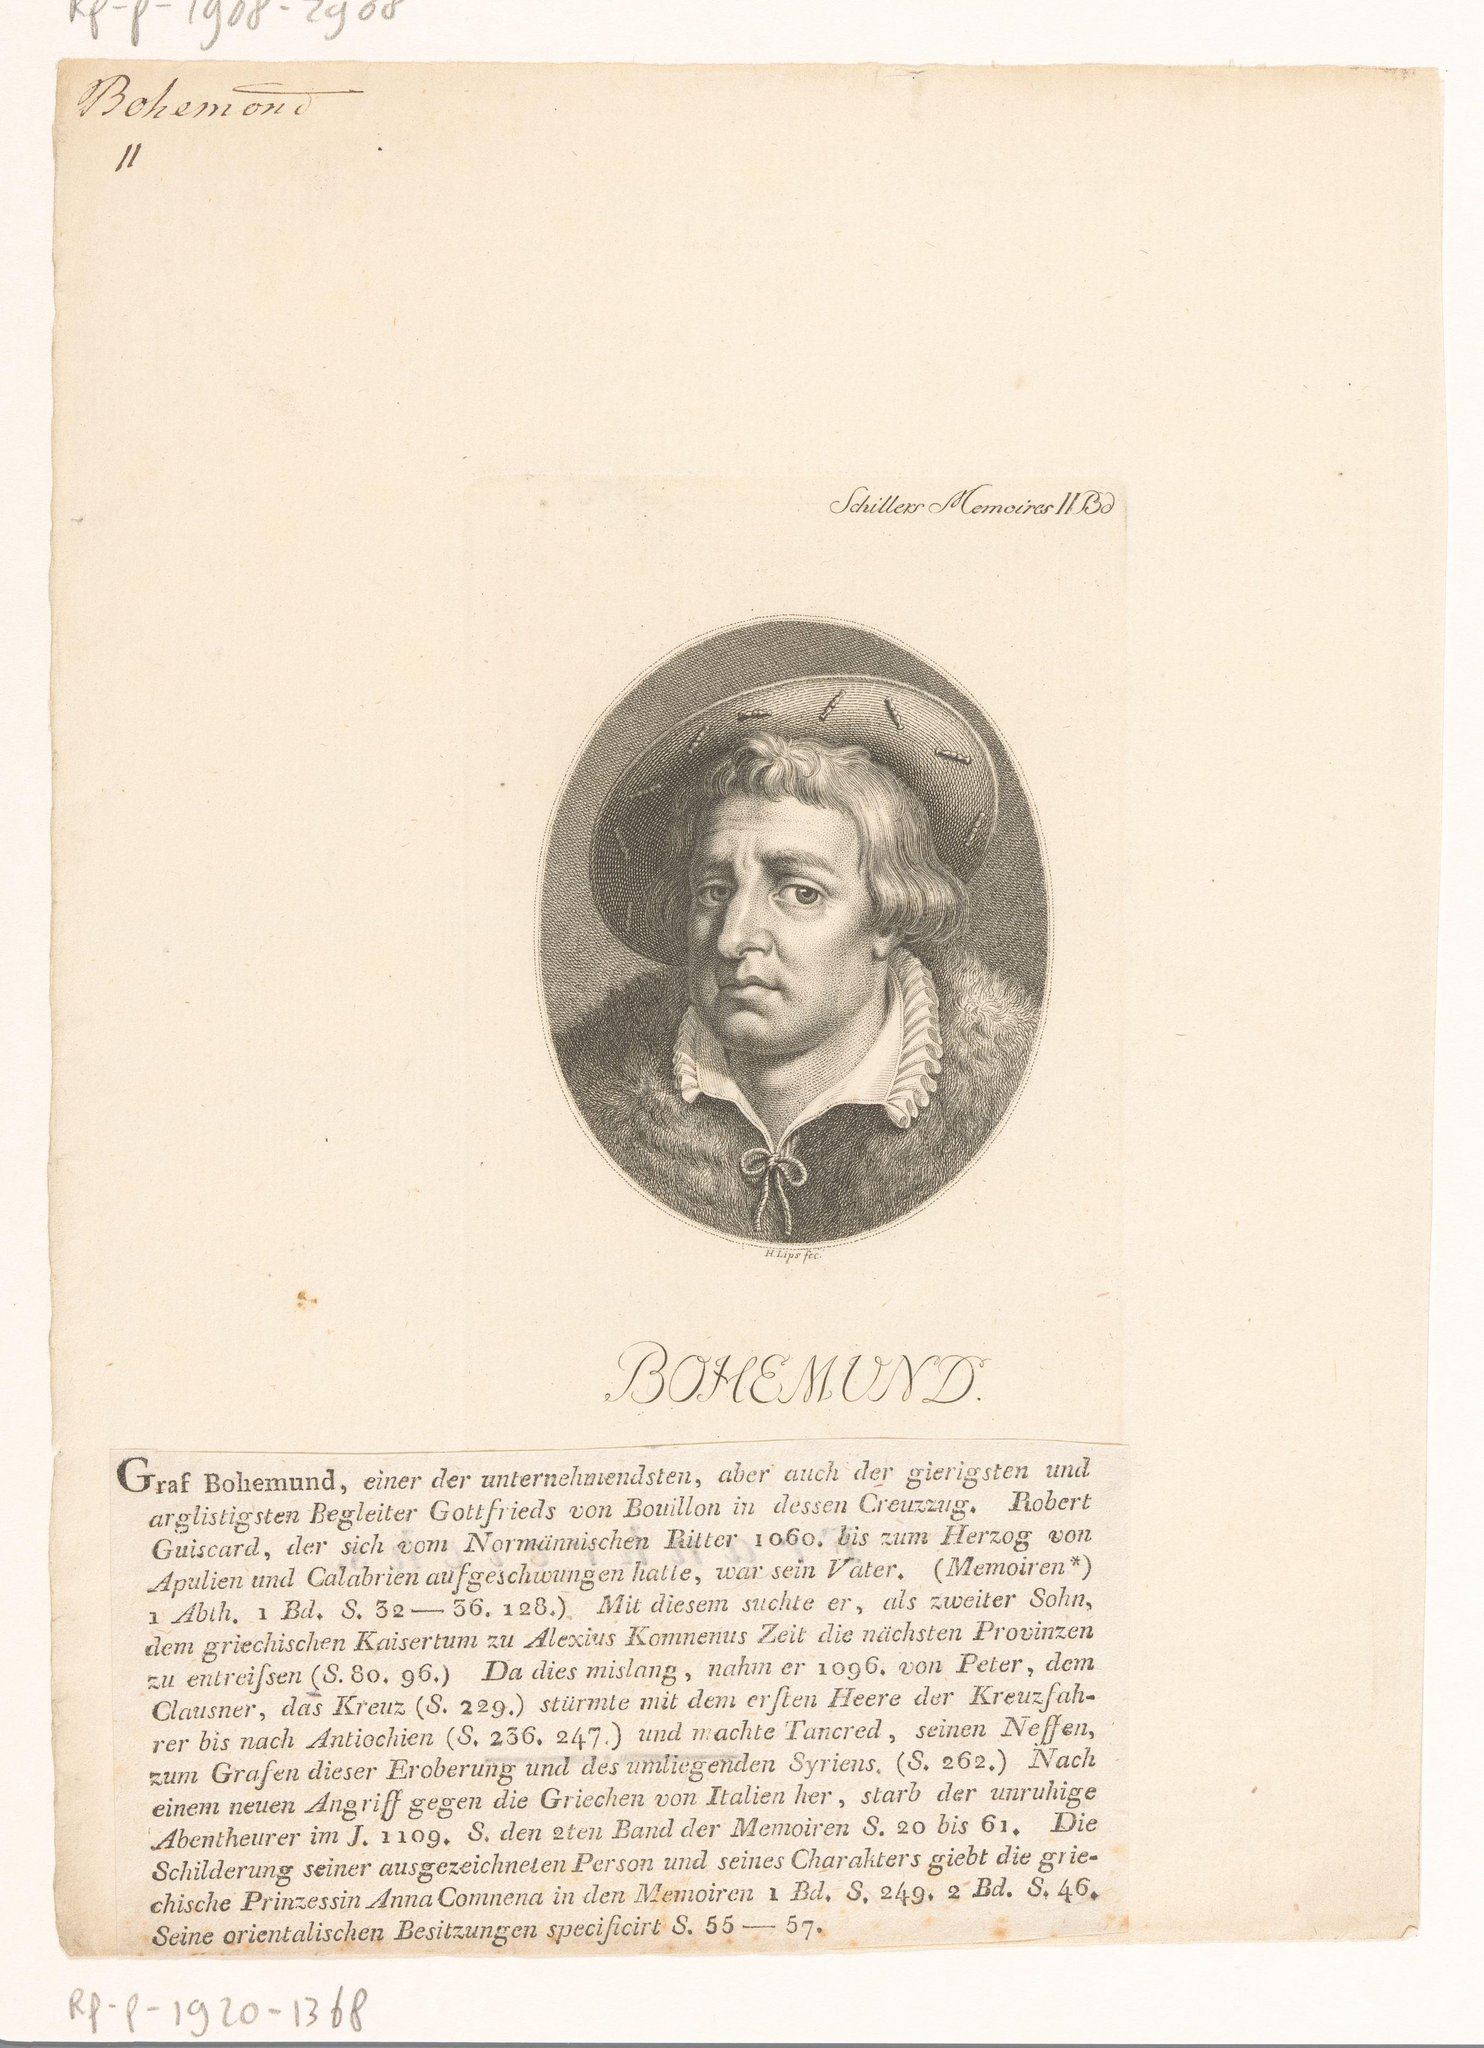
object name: print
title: Portret van Bohemund I van Antiochië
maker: johann heinrich lips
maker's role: draughtsman, painter, print maker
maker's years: 1758-1817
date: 1768-1817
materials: paper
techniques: engraving, etching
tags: historical persons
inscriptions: collector's mark: Lugt 2228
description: Blad met tekst in boekdruk op de prent geplakt.